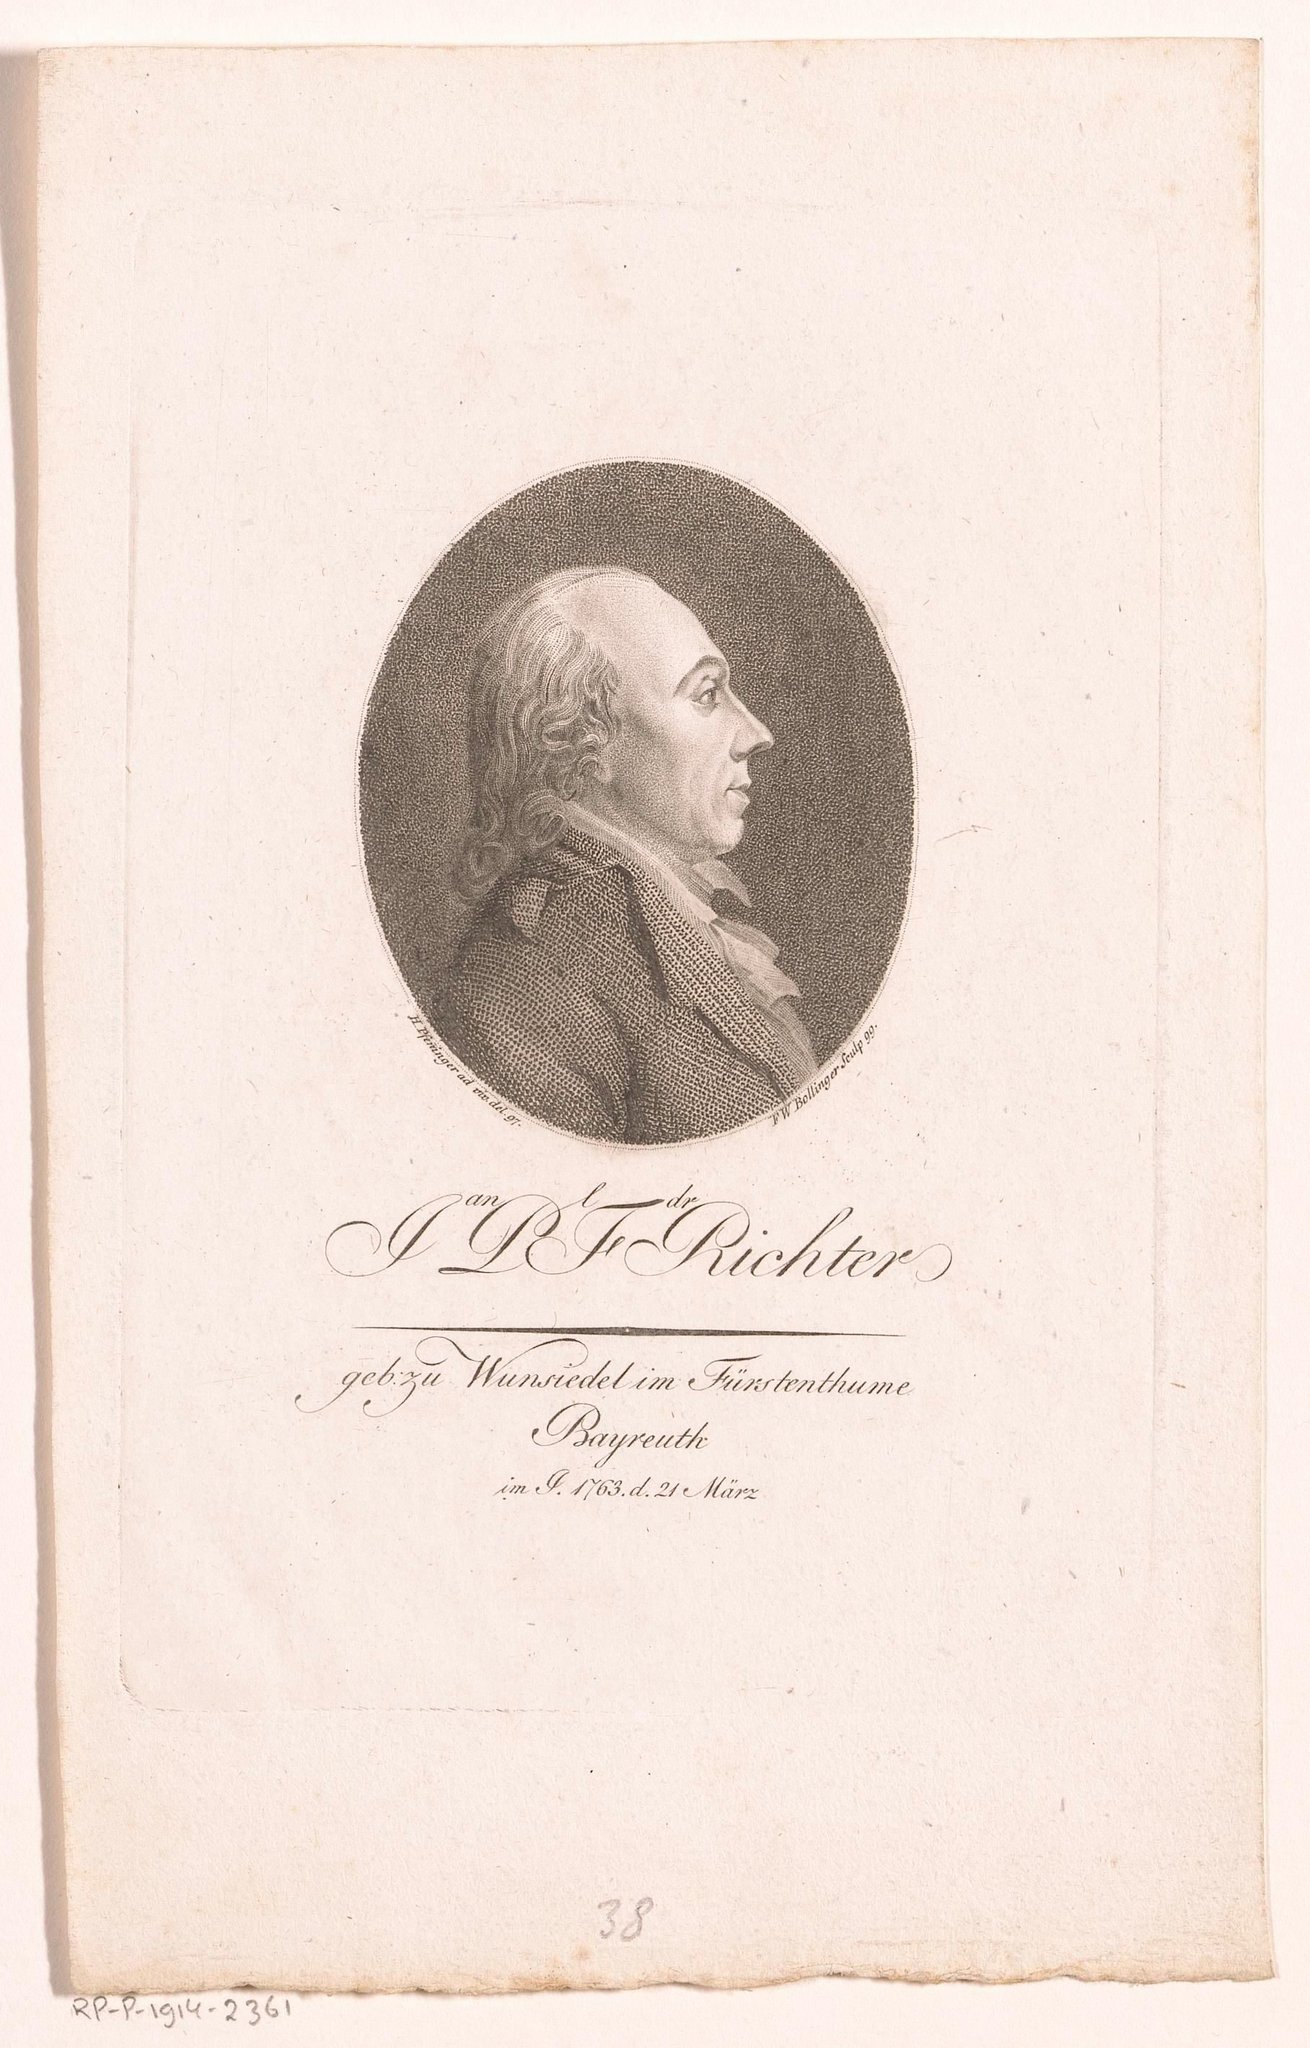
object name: print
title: Portret van Jean Paul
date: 1797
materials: paper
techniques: stippling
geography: berlin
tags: jean paul, historical persons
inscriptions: collector's mark: Lugt 2228